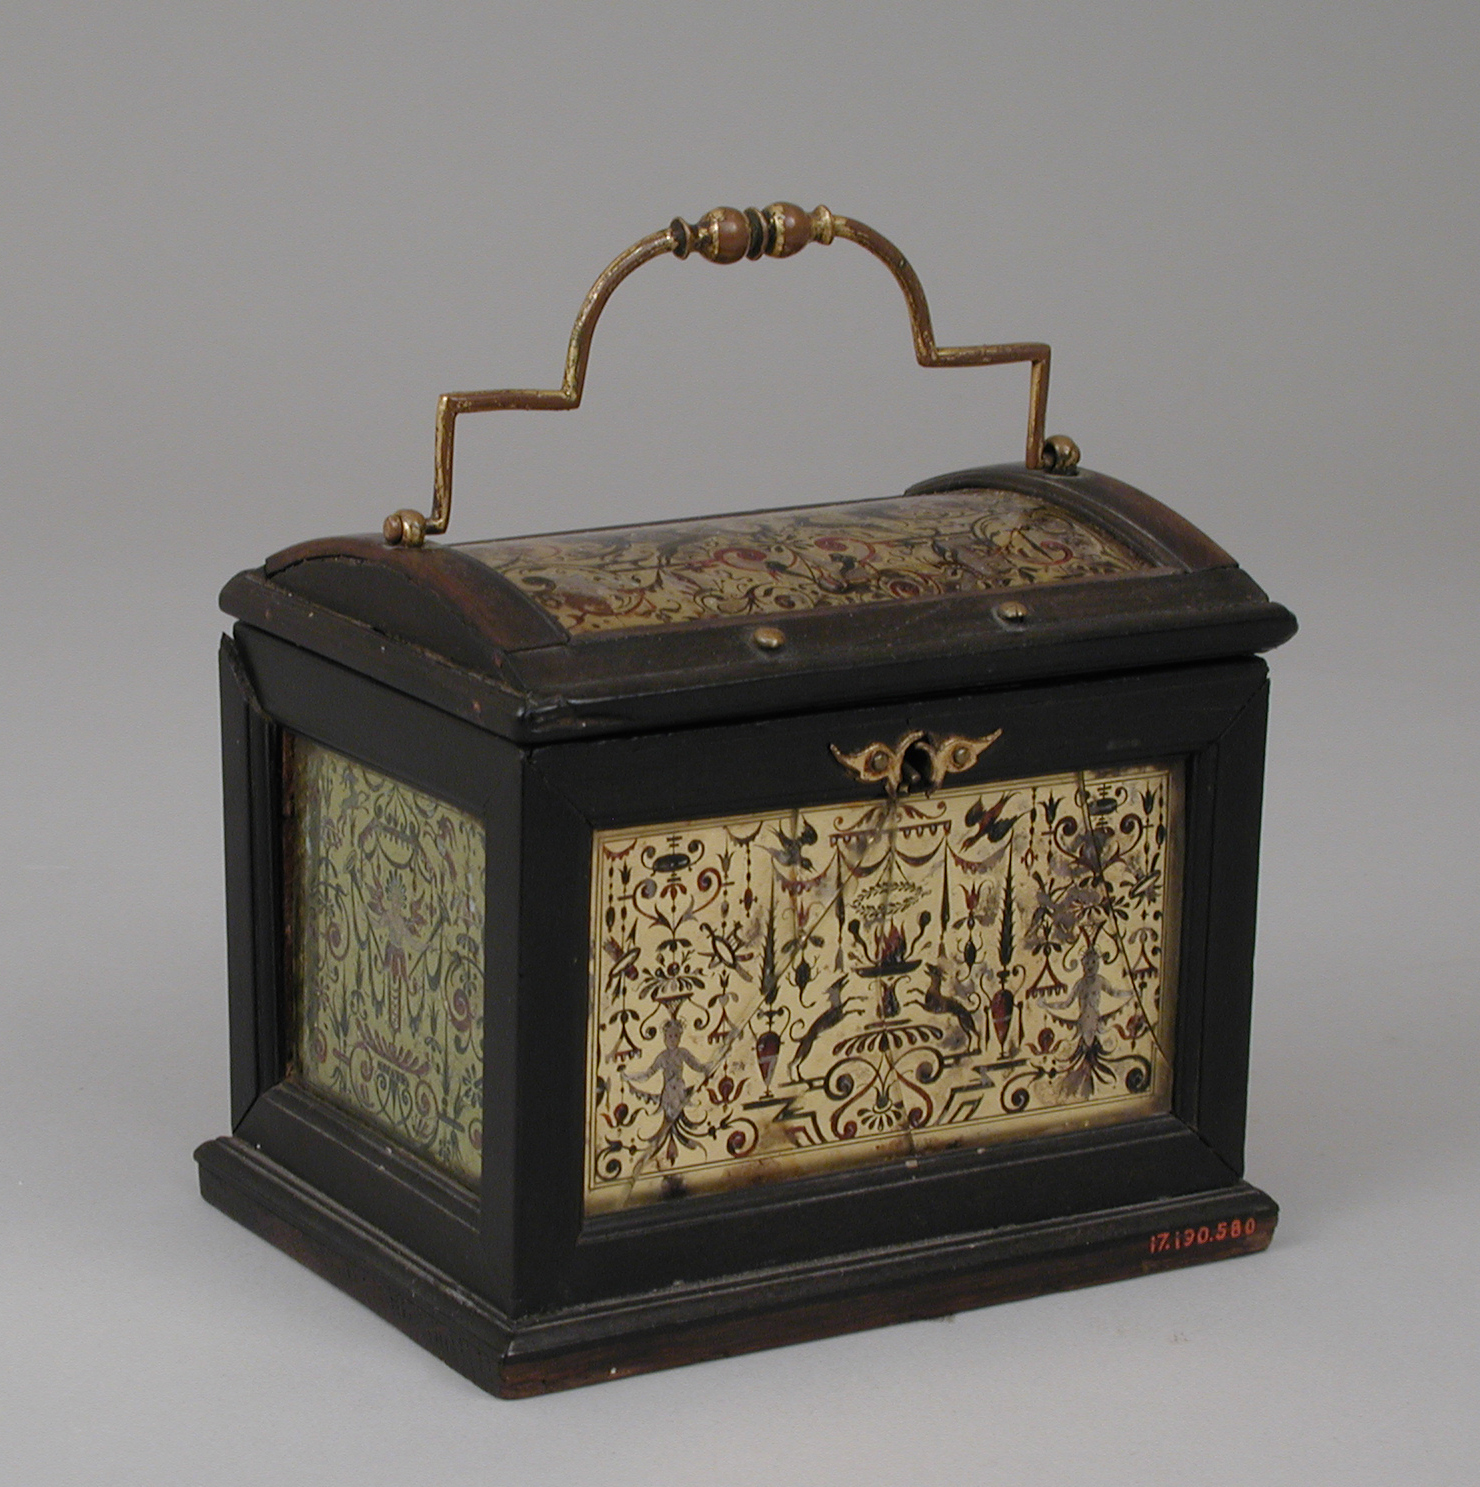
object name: casket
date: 1567-1600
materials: gilt, metal, wood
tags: animals,birds